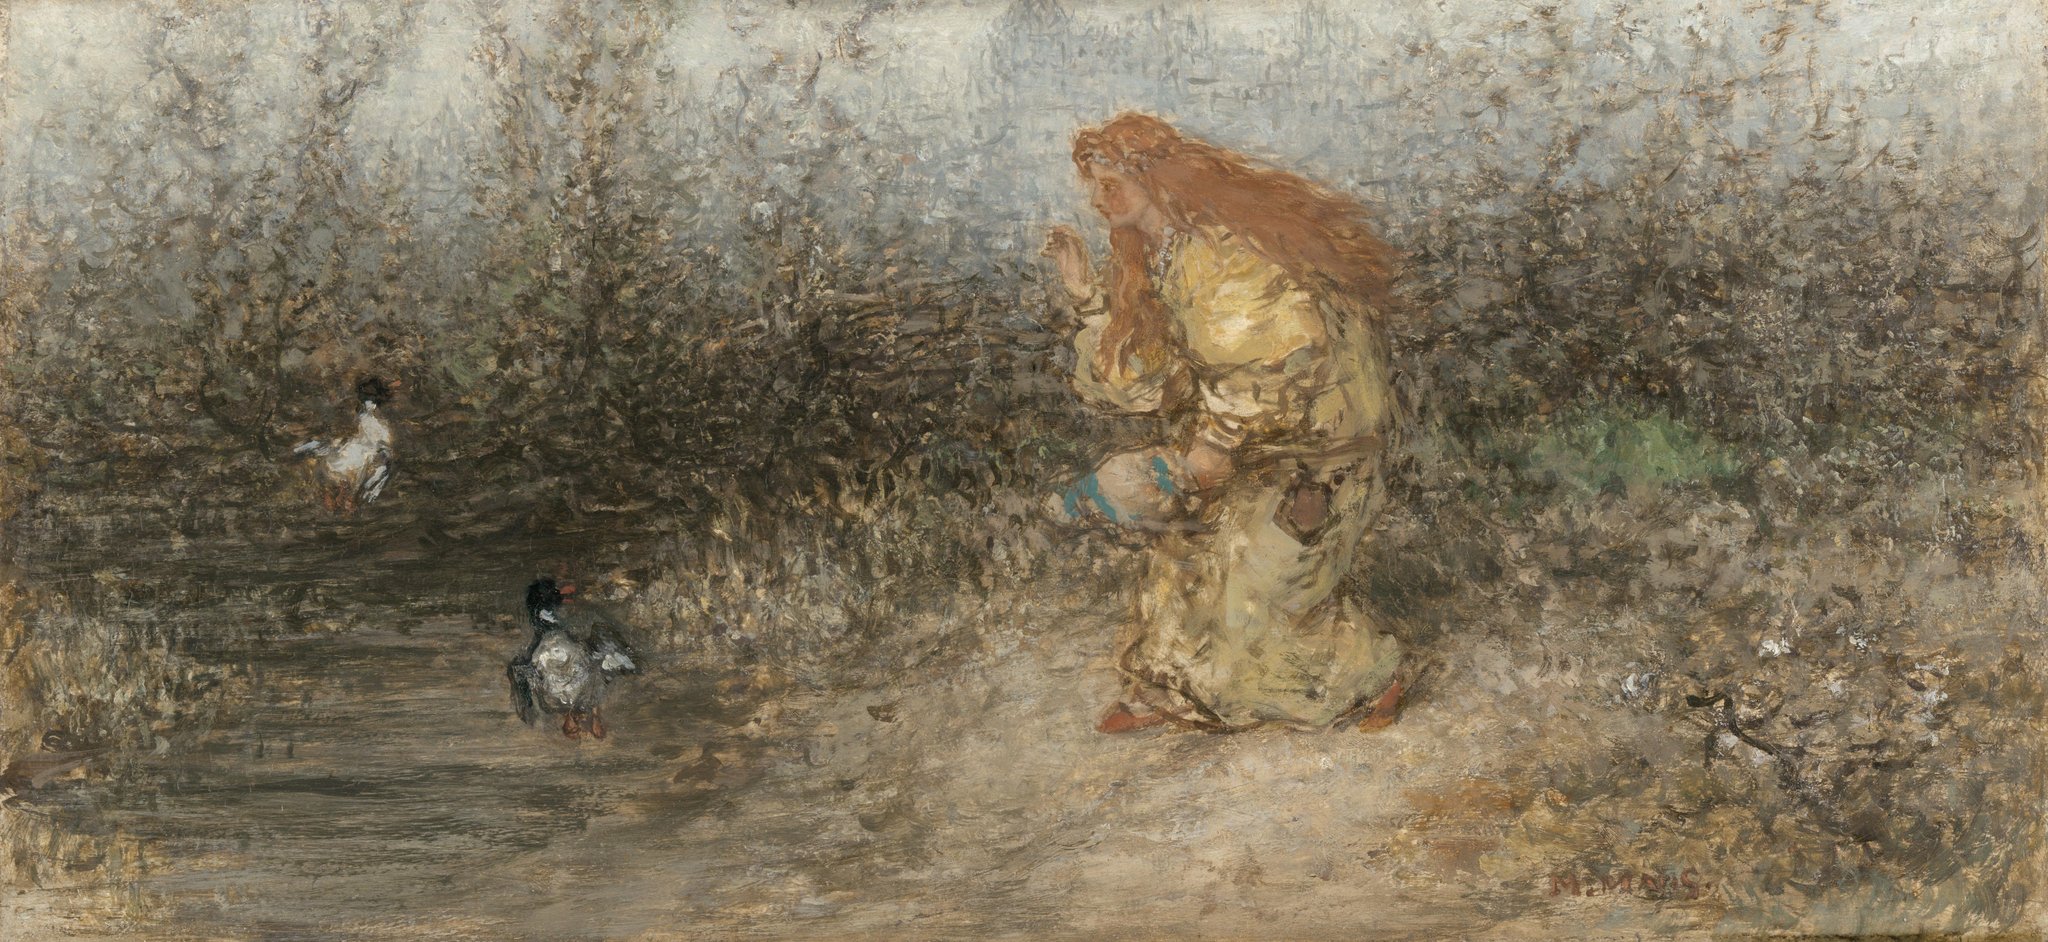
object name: painting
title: Fairy Tale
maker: matthijs maris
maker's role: draughtsman, painter, print maker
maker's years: 1839-1917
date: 1877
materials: oil, panel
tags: tales and fairy tales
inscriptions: signature: ‘M. Maris’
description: After having worked on canvas for a long time, Maris here once again chose a wood panel as his support. He first painted the woman, then her immediate surroundings, and lastly the sky. The smooth wood gave him the freedom to play with different brushwork: the sky and the woman are thinly brushed with diluted oil paint resembling watercolour, while the foliage is rendered with spirited short strokes.